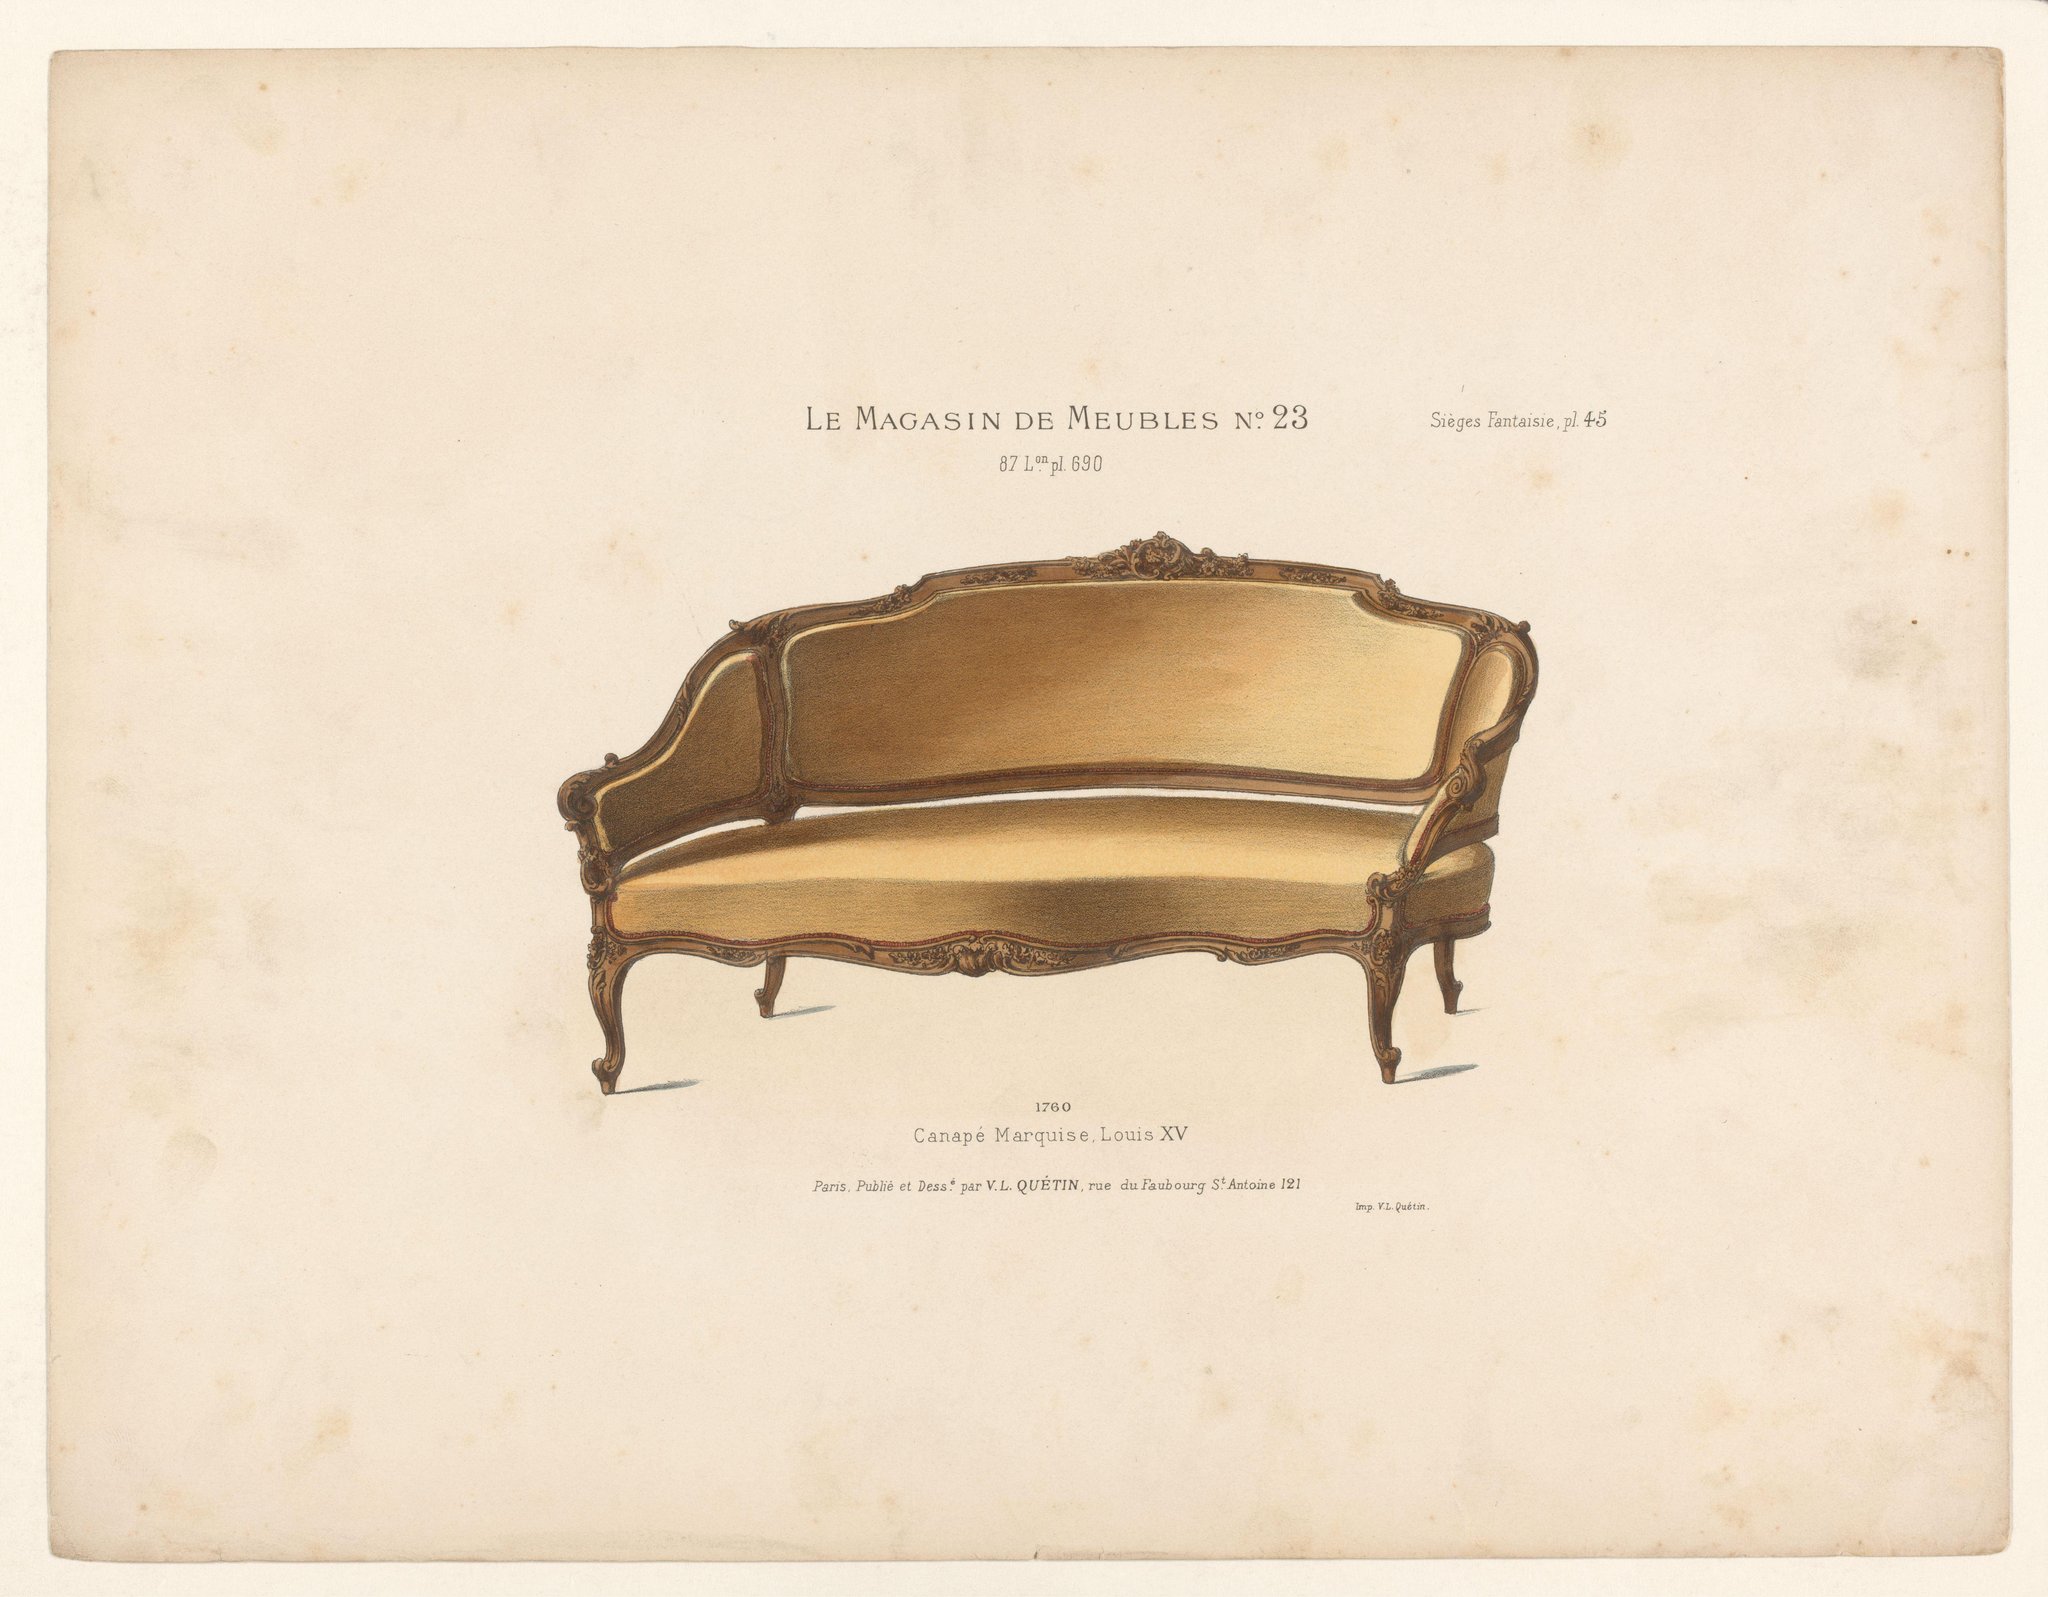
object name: print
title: Canapé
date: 1878-1904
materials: paper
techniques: hand coloring, lithograph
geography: paris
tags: seating furniture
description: Een canapé in de Lodewijk XV-stijl. Prent uit 87e Livraison. Rechts boven de vermelding Sièges Fantaisie, pl. 45.